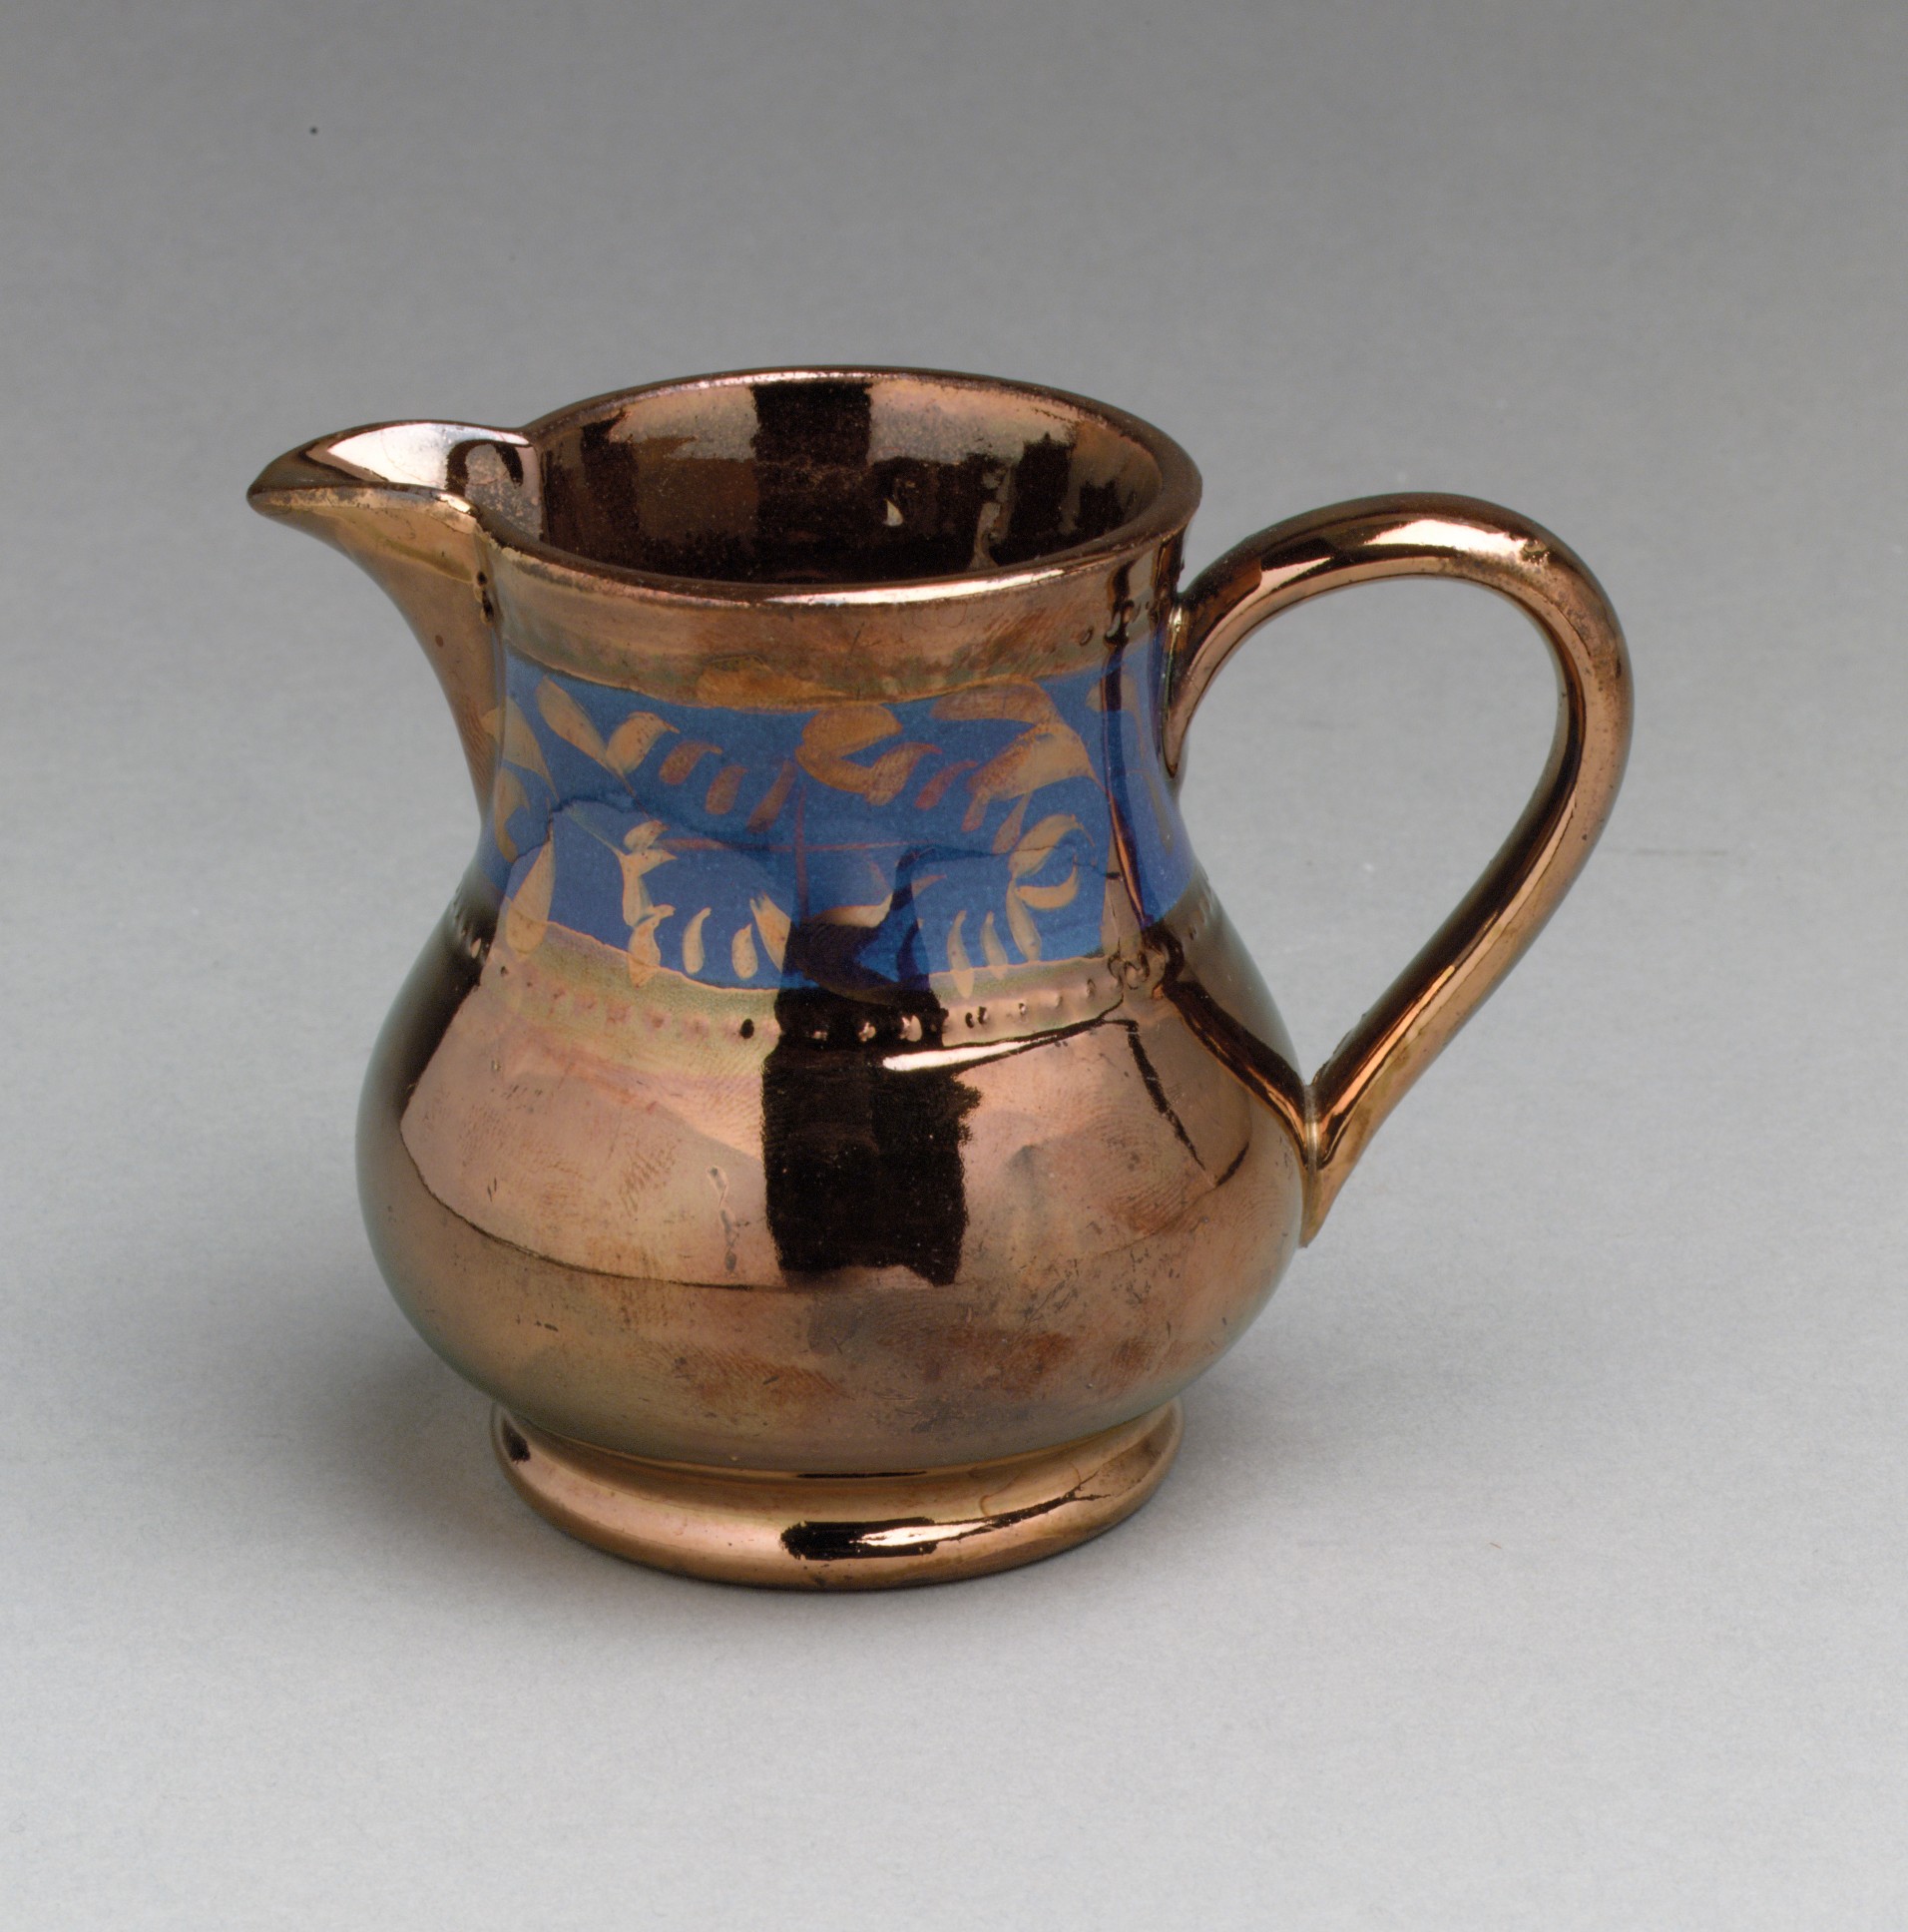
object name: pitcher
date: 1801-1900